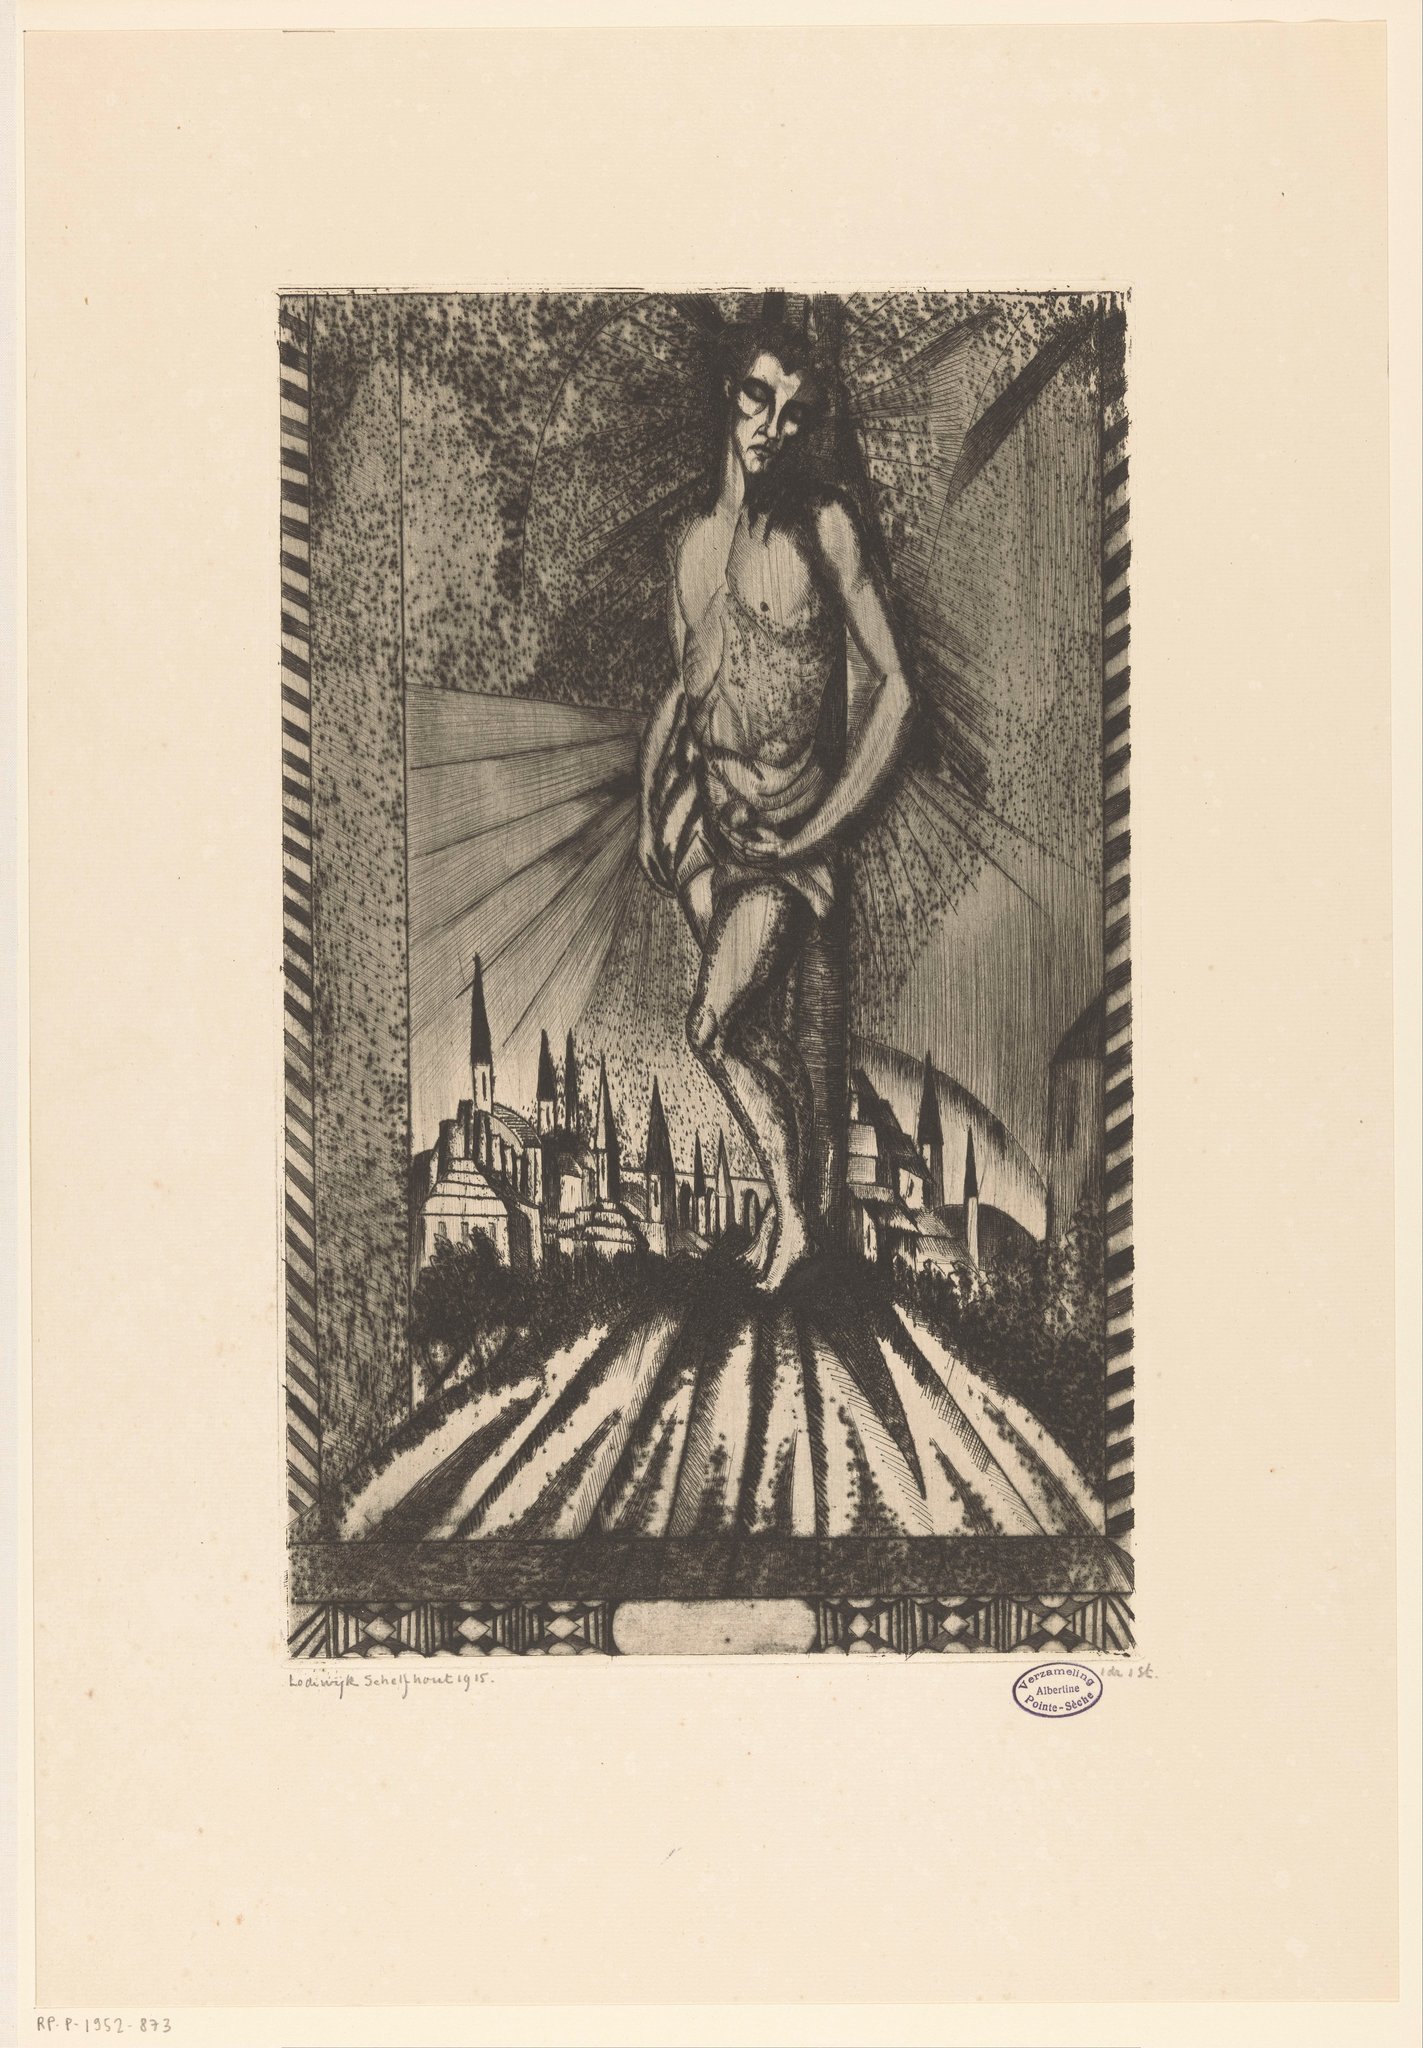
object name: print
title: Saint Sébastien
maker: lodewijk schelfhout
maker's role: draughtsman, print maker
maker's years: 1881-1943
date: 1915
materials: paper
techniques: drypoint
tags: partially clothed, the martyr sebastian; possible attributes: arrow(s), bow, tree-trunk, landscape with tower or castle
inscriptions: collector's mark: Lugt 2228, collector's mark: Lugt 5i, collector's mark: Lugt 2760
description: De heilige Sebastiaan, gekleed in een lendendoek, staand tegen een boom of paal. Op de achtergrond gebouwen met torens.